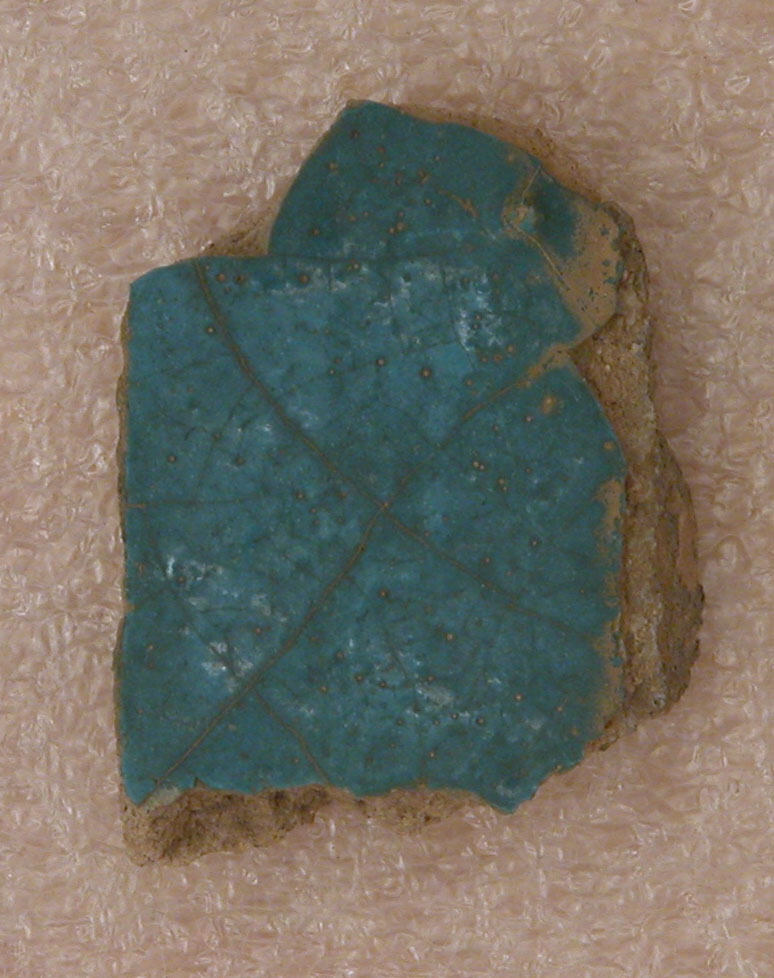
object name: tile fragment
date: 1334-1434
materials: stonepaste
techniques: glazing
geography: uzbekistan